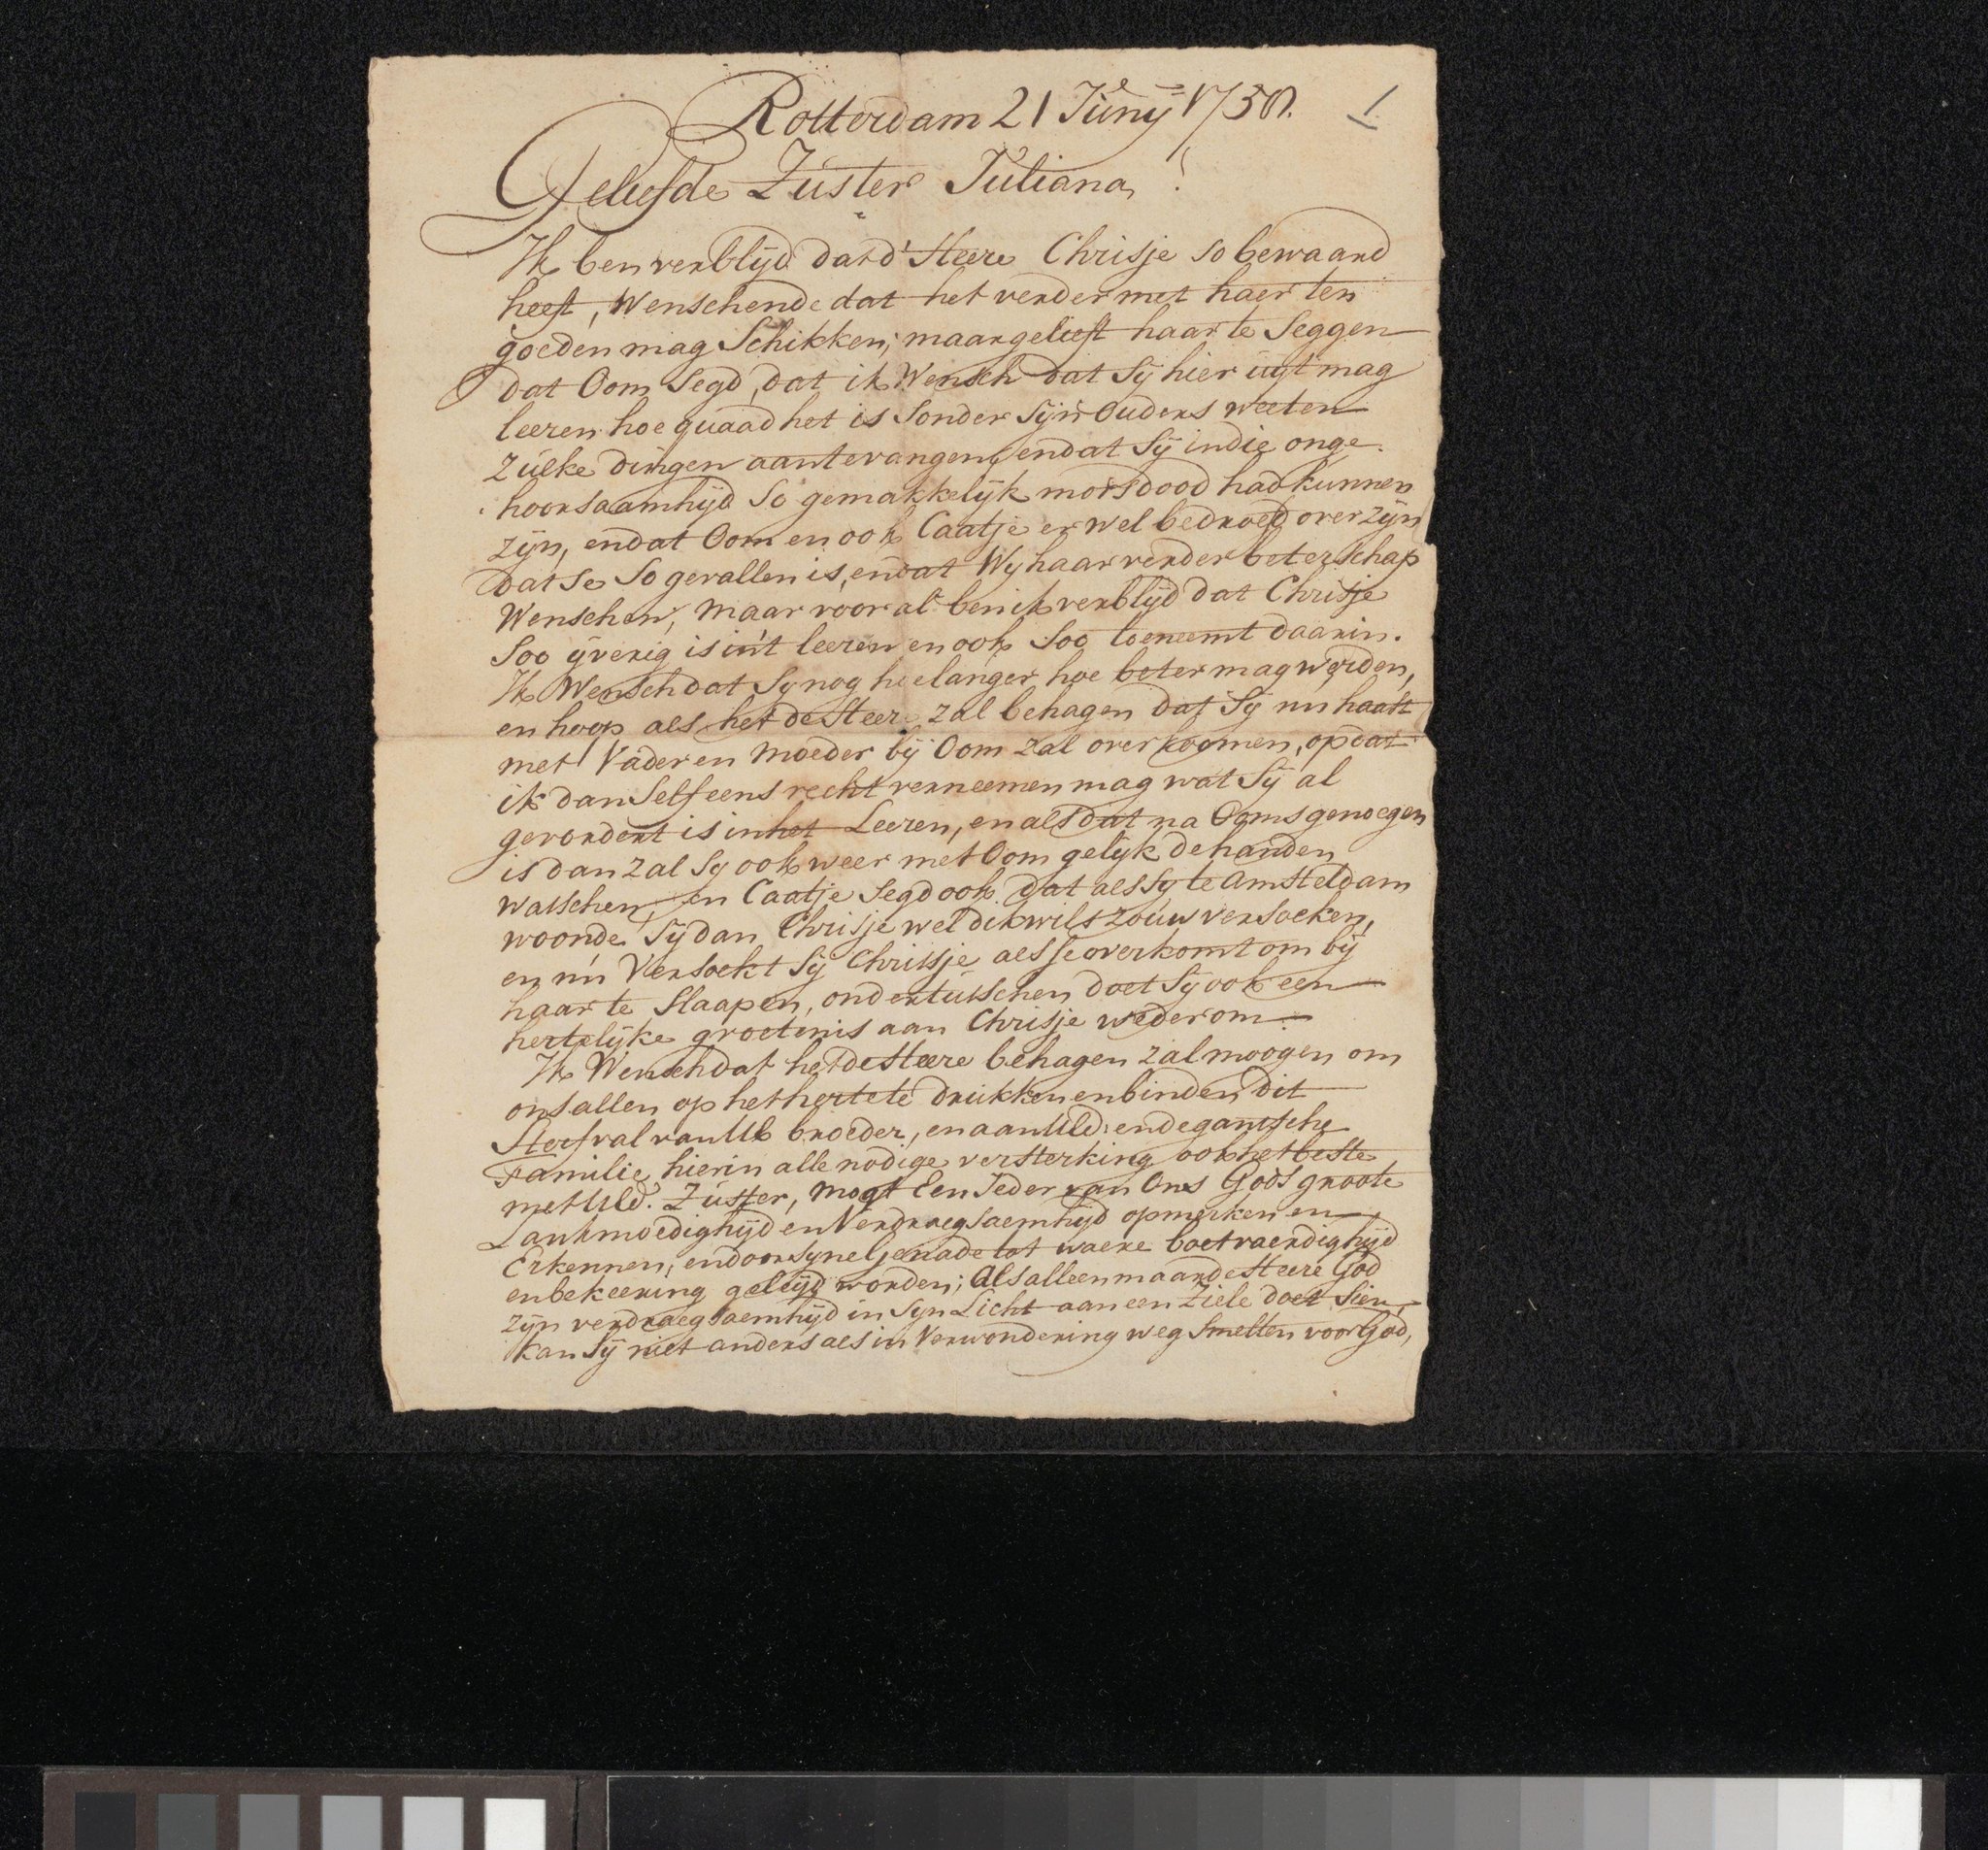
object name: letter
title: Brief aan Juliana Charlotte Elisabeth Backhuijzen-Parmesant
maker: gerrit backhuijzen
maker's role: draughtsman, painter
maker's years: 1721-1760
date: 1758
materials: ink, paper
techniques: pen, writing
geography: rotterdam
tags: dordrecht, tibout regters, family life, christian religion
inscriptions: collector's mark: Lugt 2233, watermark